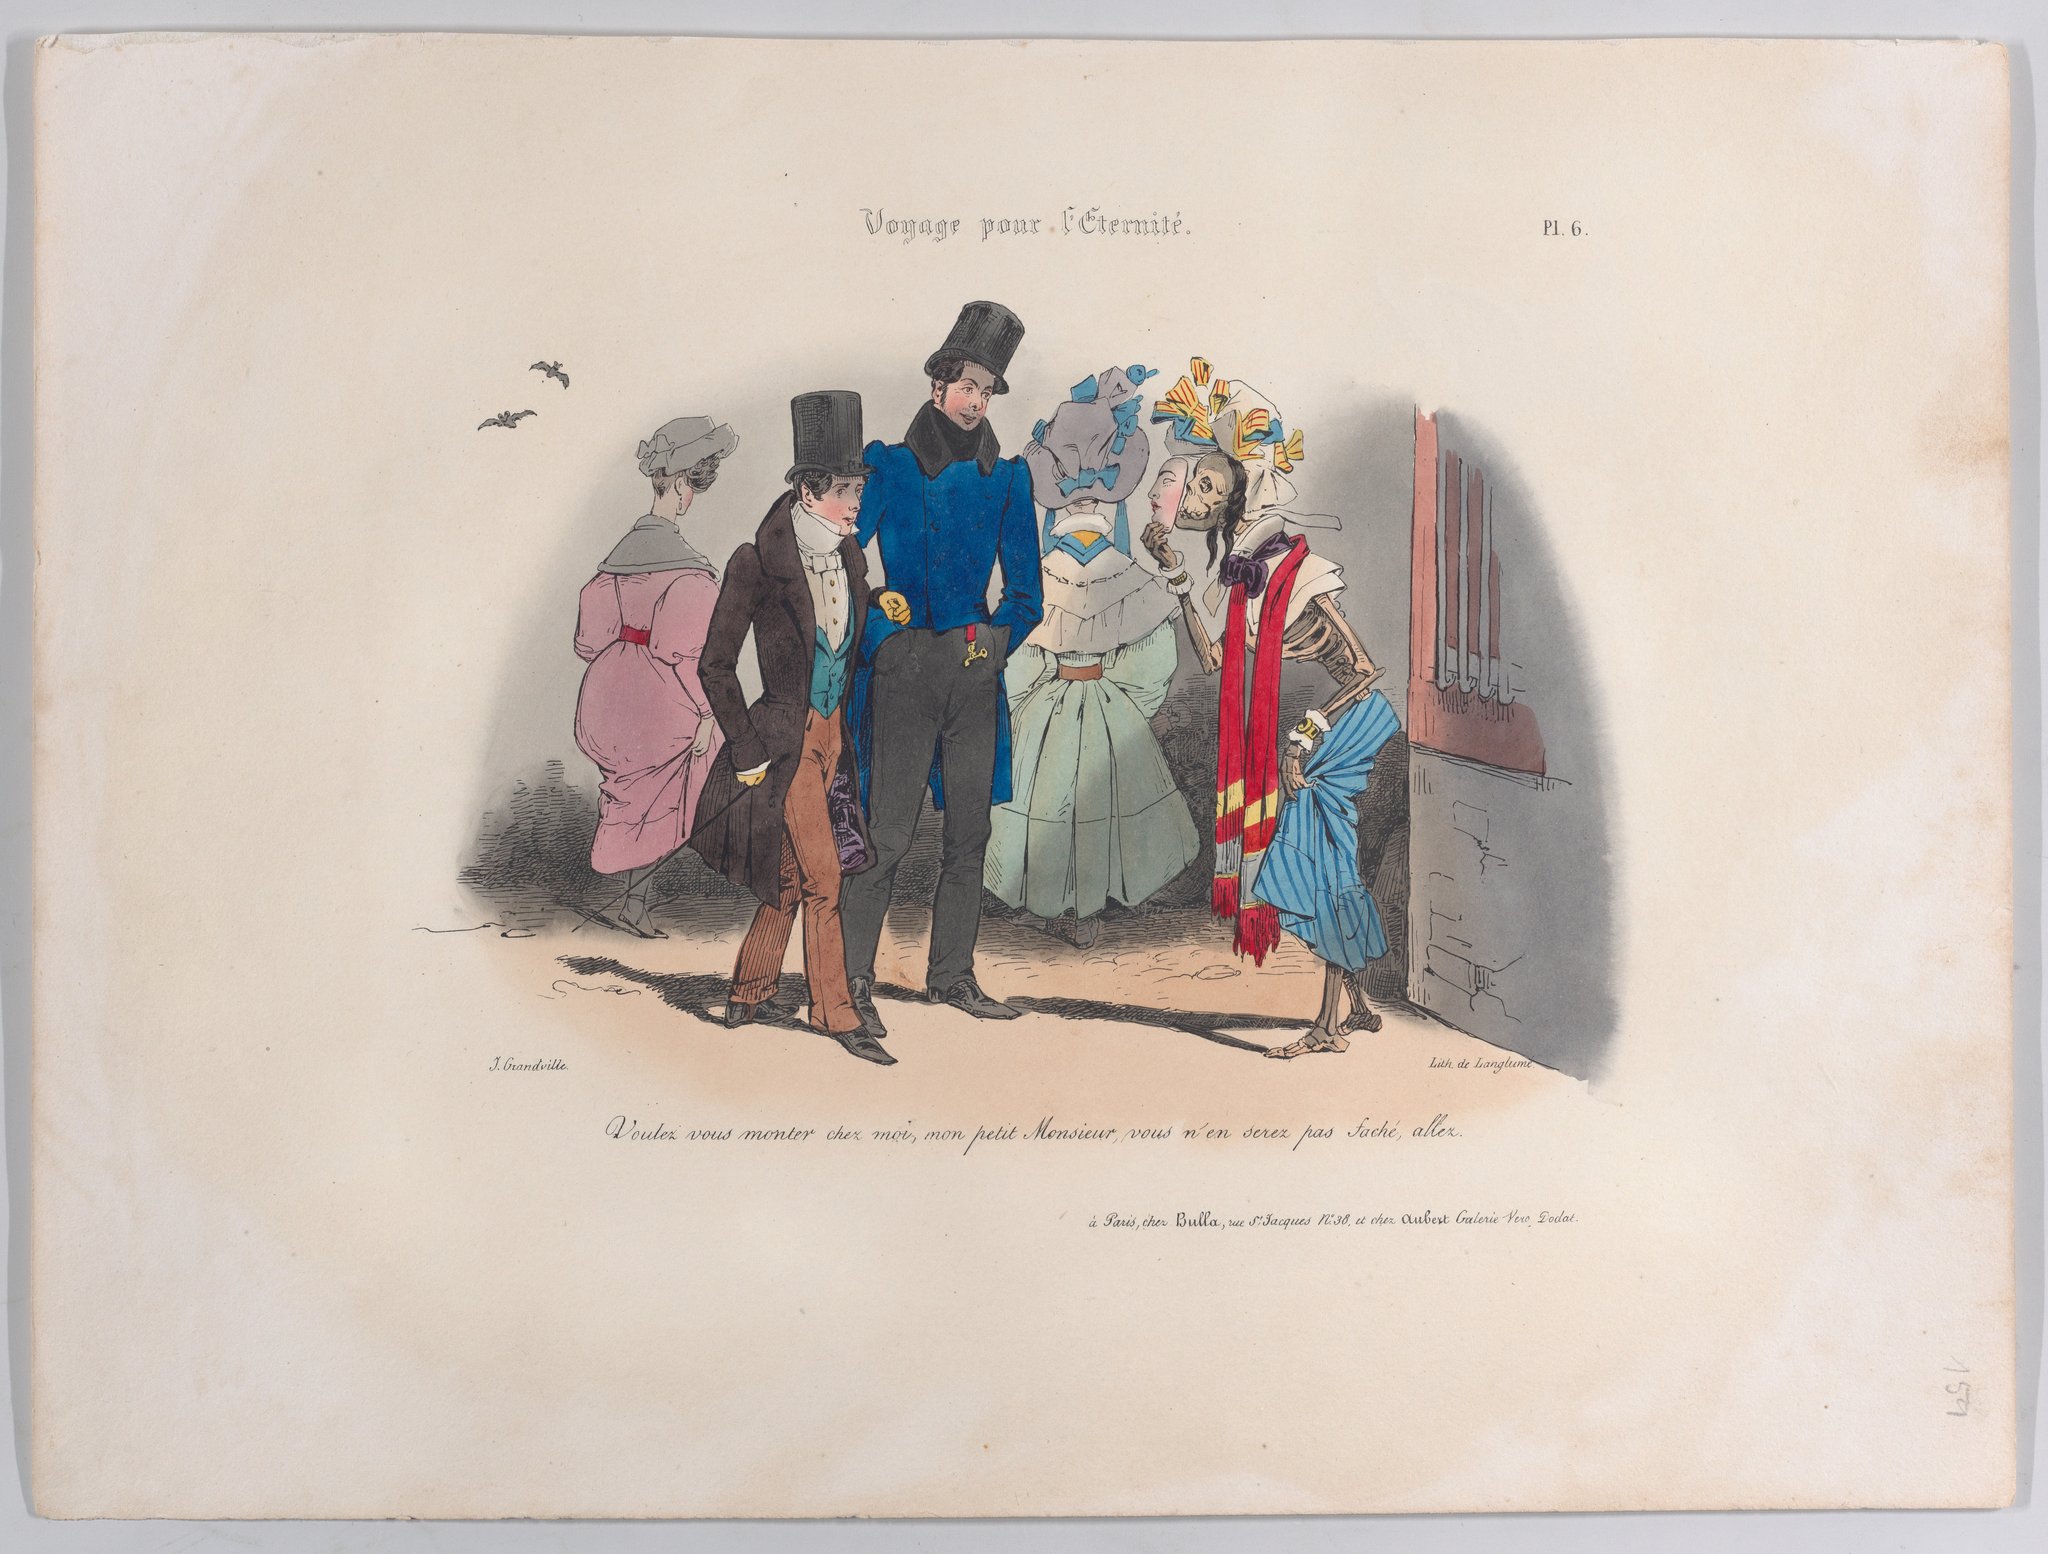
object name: print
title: Journey for Eternity, No. 7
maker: j. j. grandville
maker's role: designer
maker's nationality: french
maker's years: 1803-1847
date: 1839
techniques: lithograph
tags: skeletons,men,women